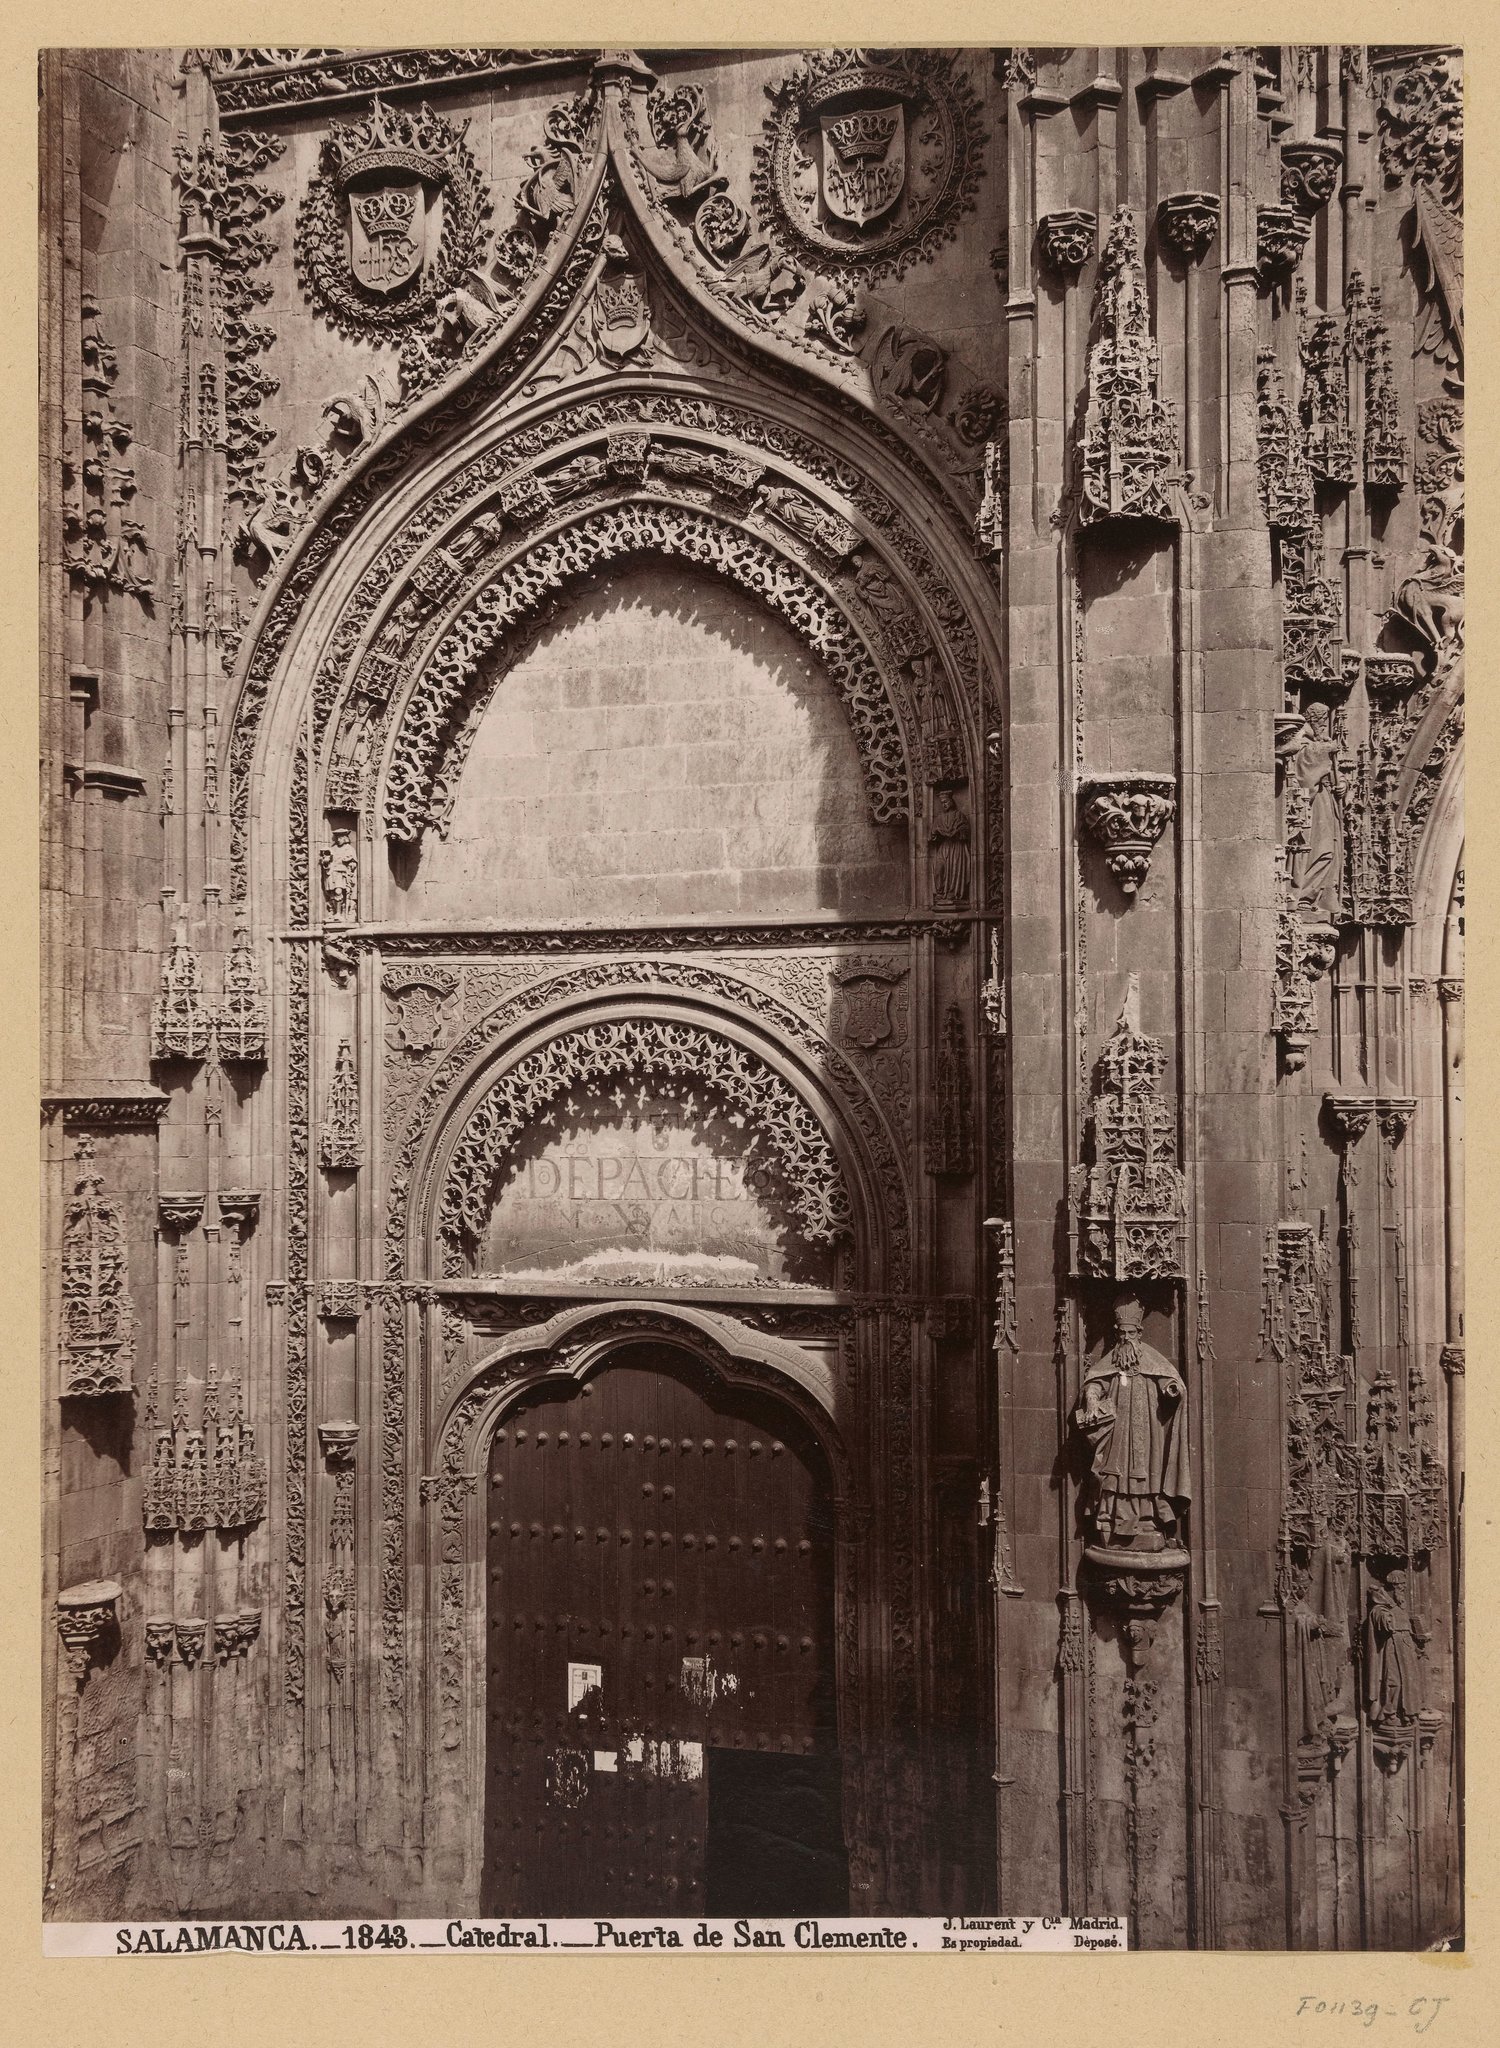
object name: album leaf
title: Salamanca, Catedral, Puerta de San Clemente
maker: juan laurent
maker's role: publisher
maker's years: 1816-1896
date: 1863-1883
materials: paper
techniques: albumen print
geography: salamanca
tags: church (exterior)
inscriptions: inscription: ‘Es propiedad./ Déposé.’, number: ‘1843’